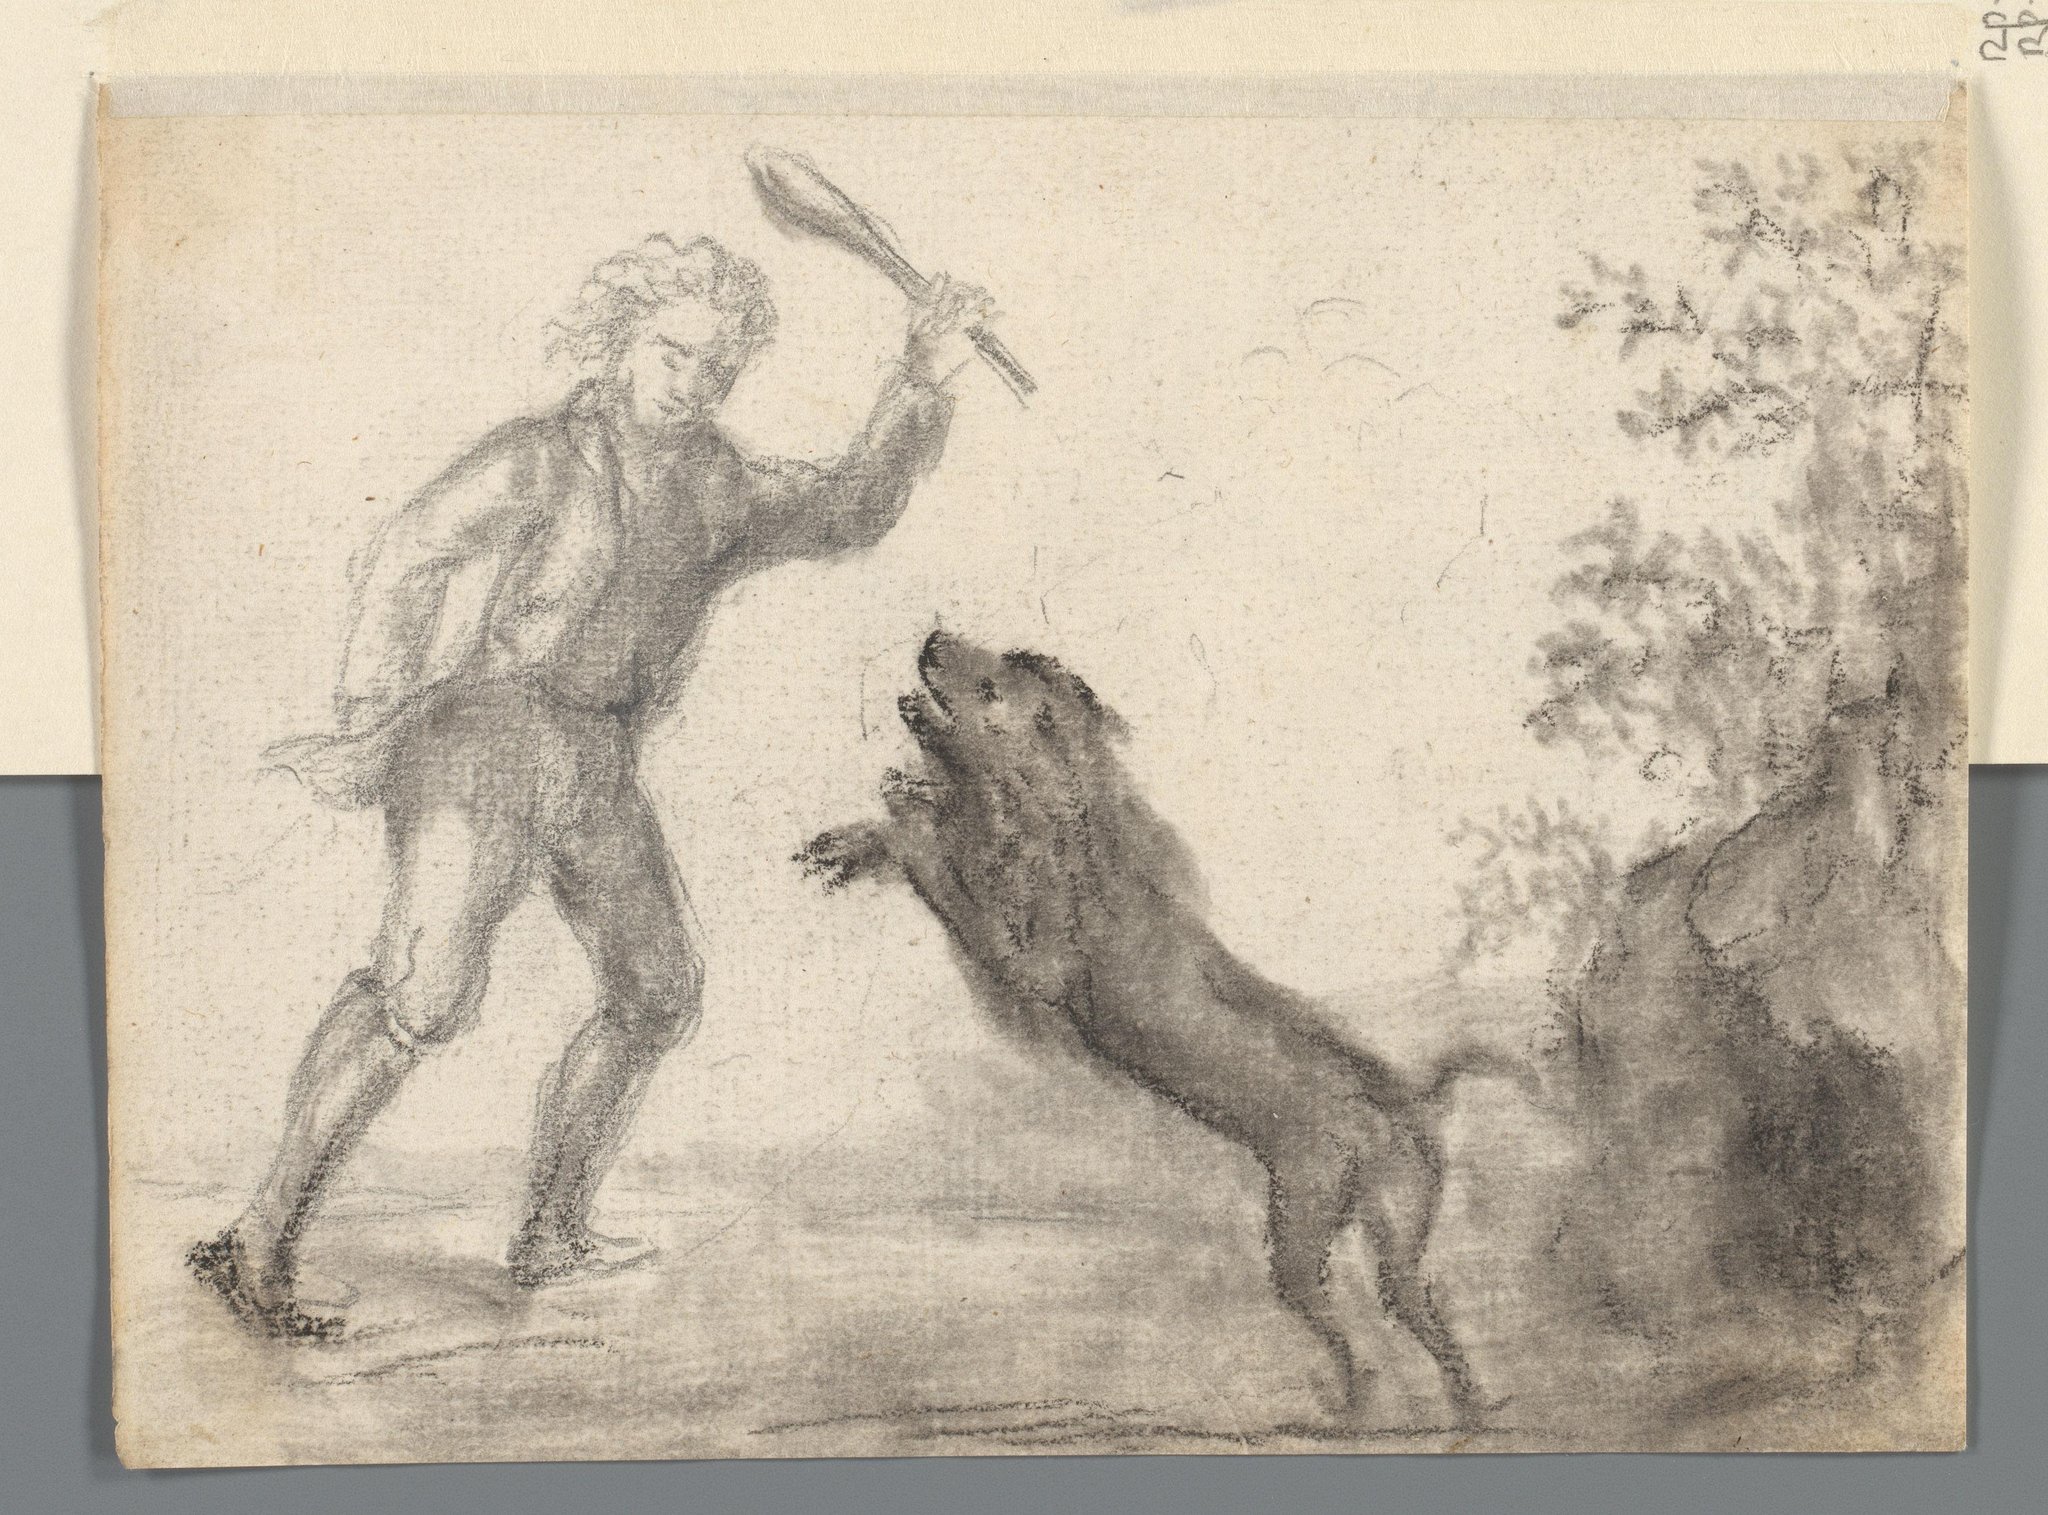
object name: drawing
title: Man met knuppel bedreigt een opspringende hond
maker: Anonymous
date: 1750-1820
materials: chalk, paper, pencil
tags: standing figure, weapons for striking a blow: club, dog